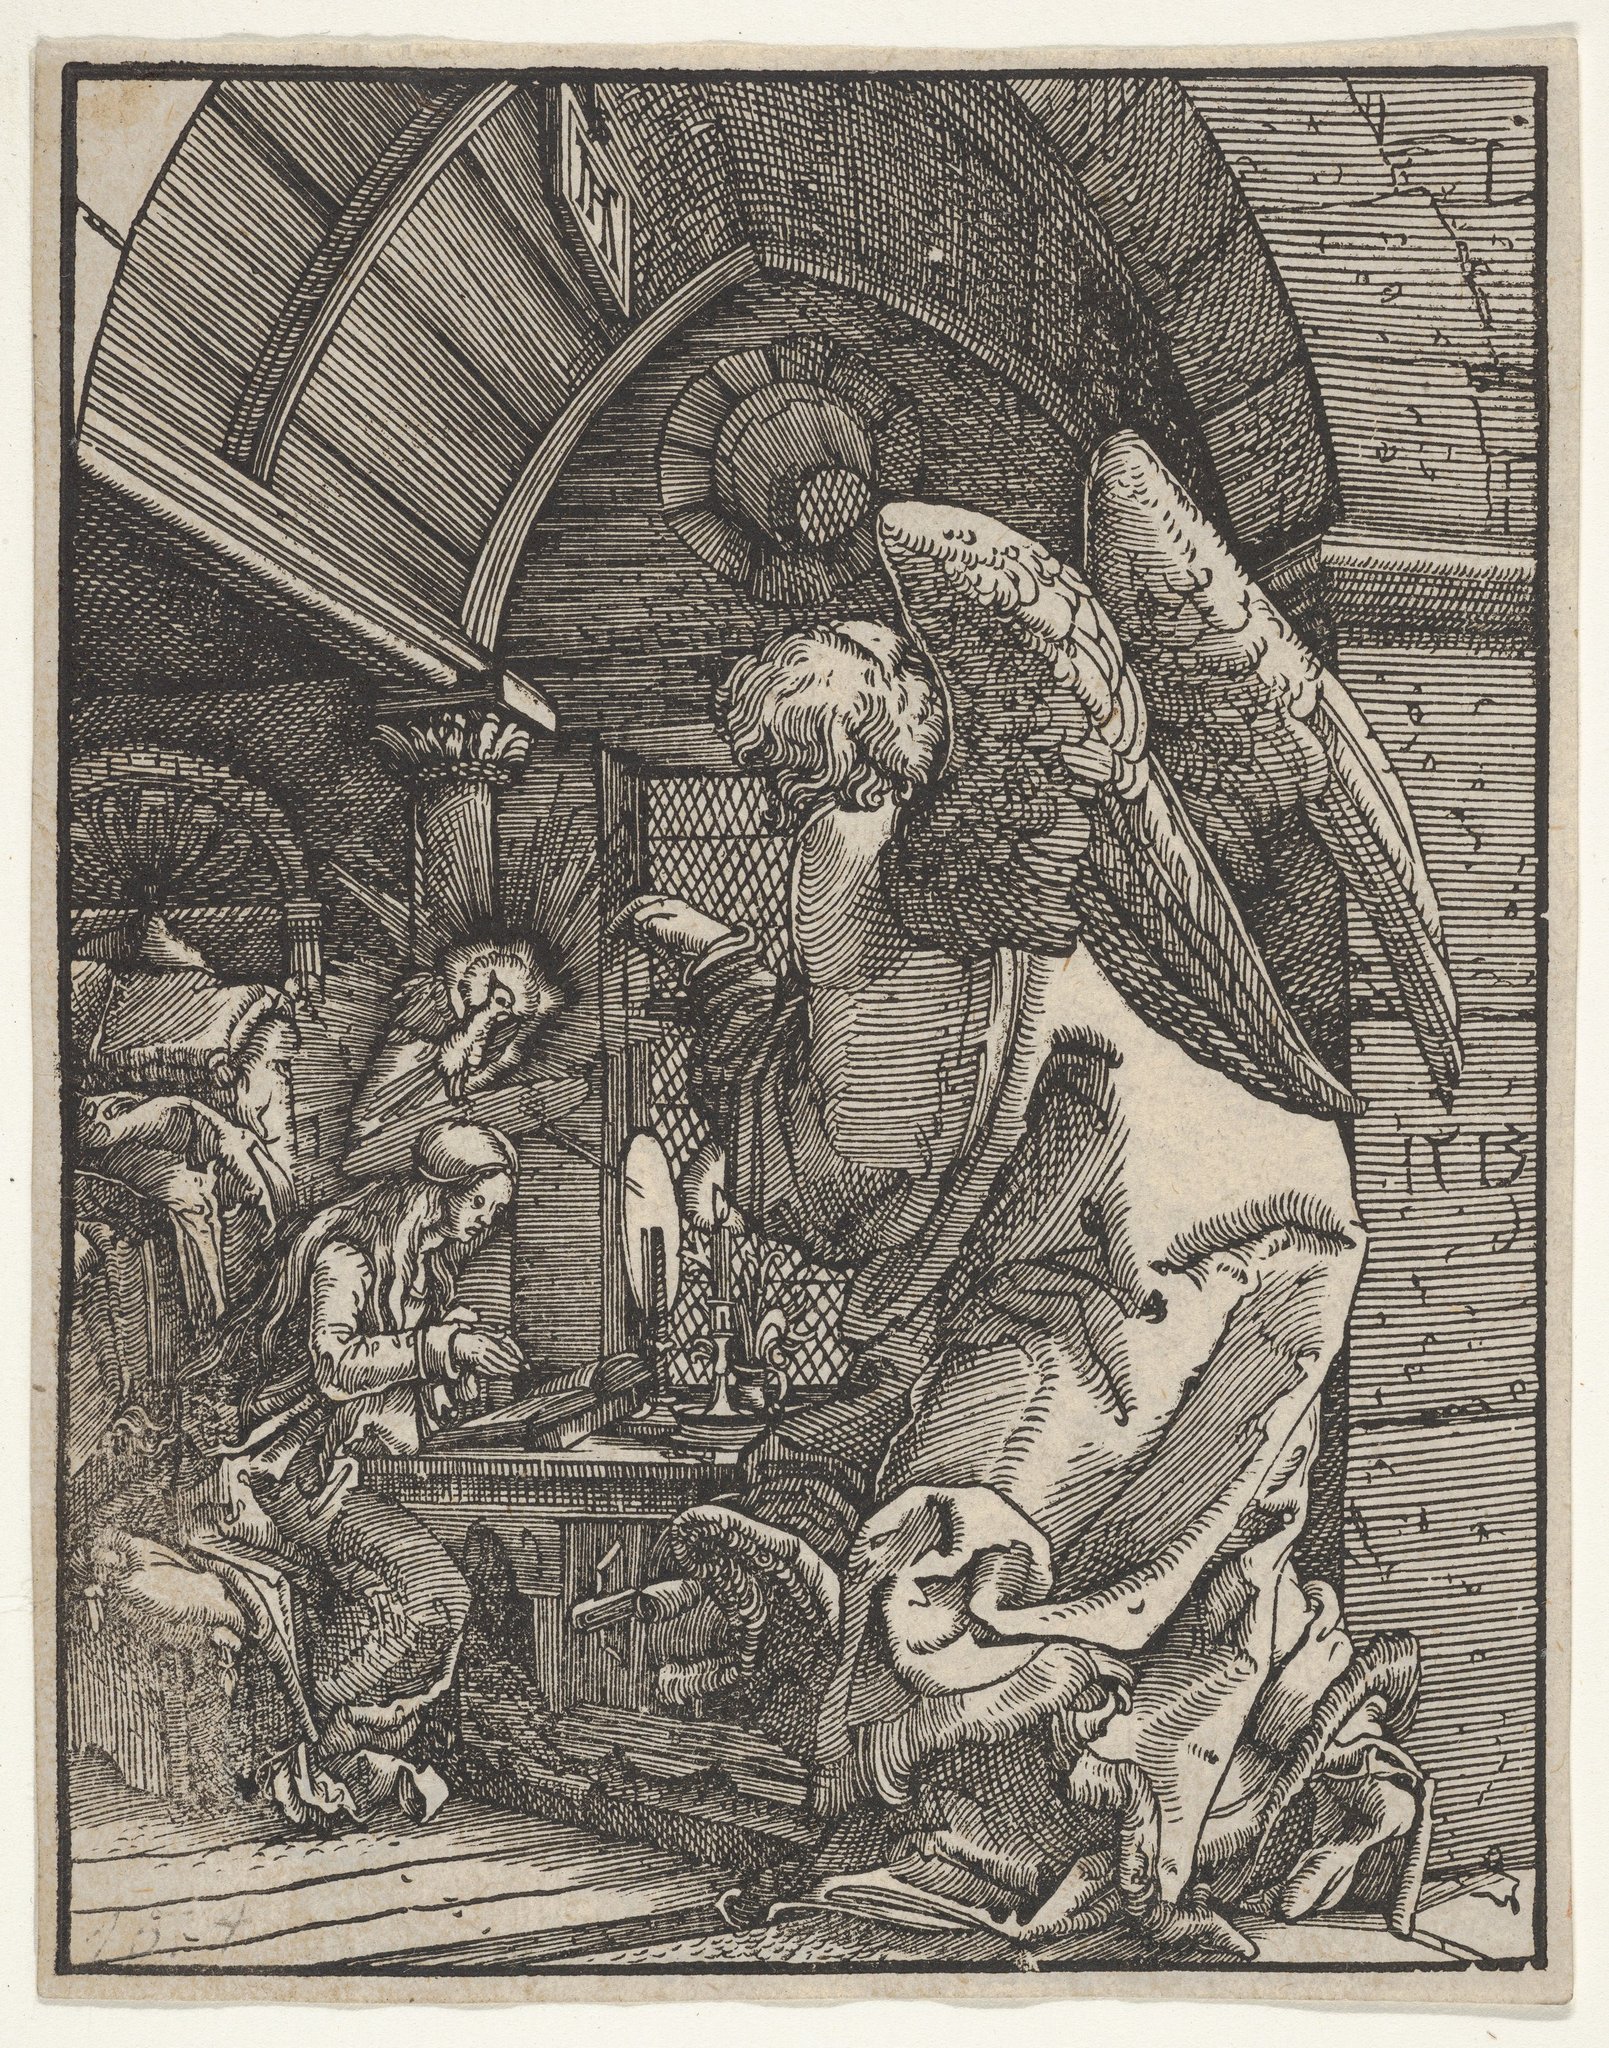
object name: print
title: The Annunciation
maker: albrecht altdorfer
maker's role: artist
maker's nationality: german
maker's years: 1480-1538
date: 1513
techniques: woodcut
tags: birds,angels,virgin mary,annunciation